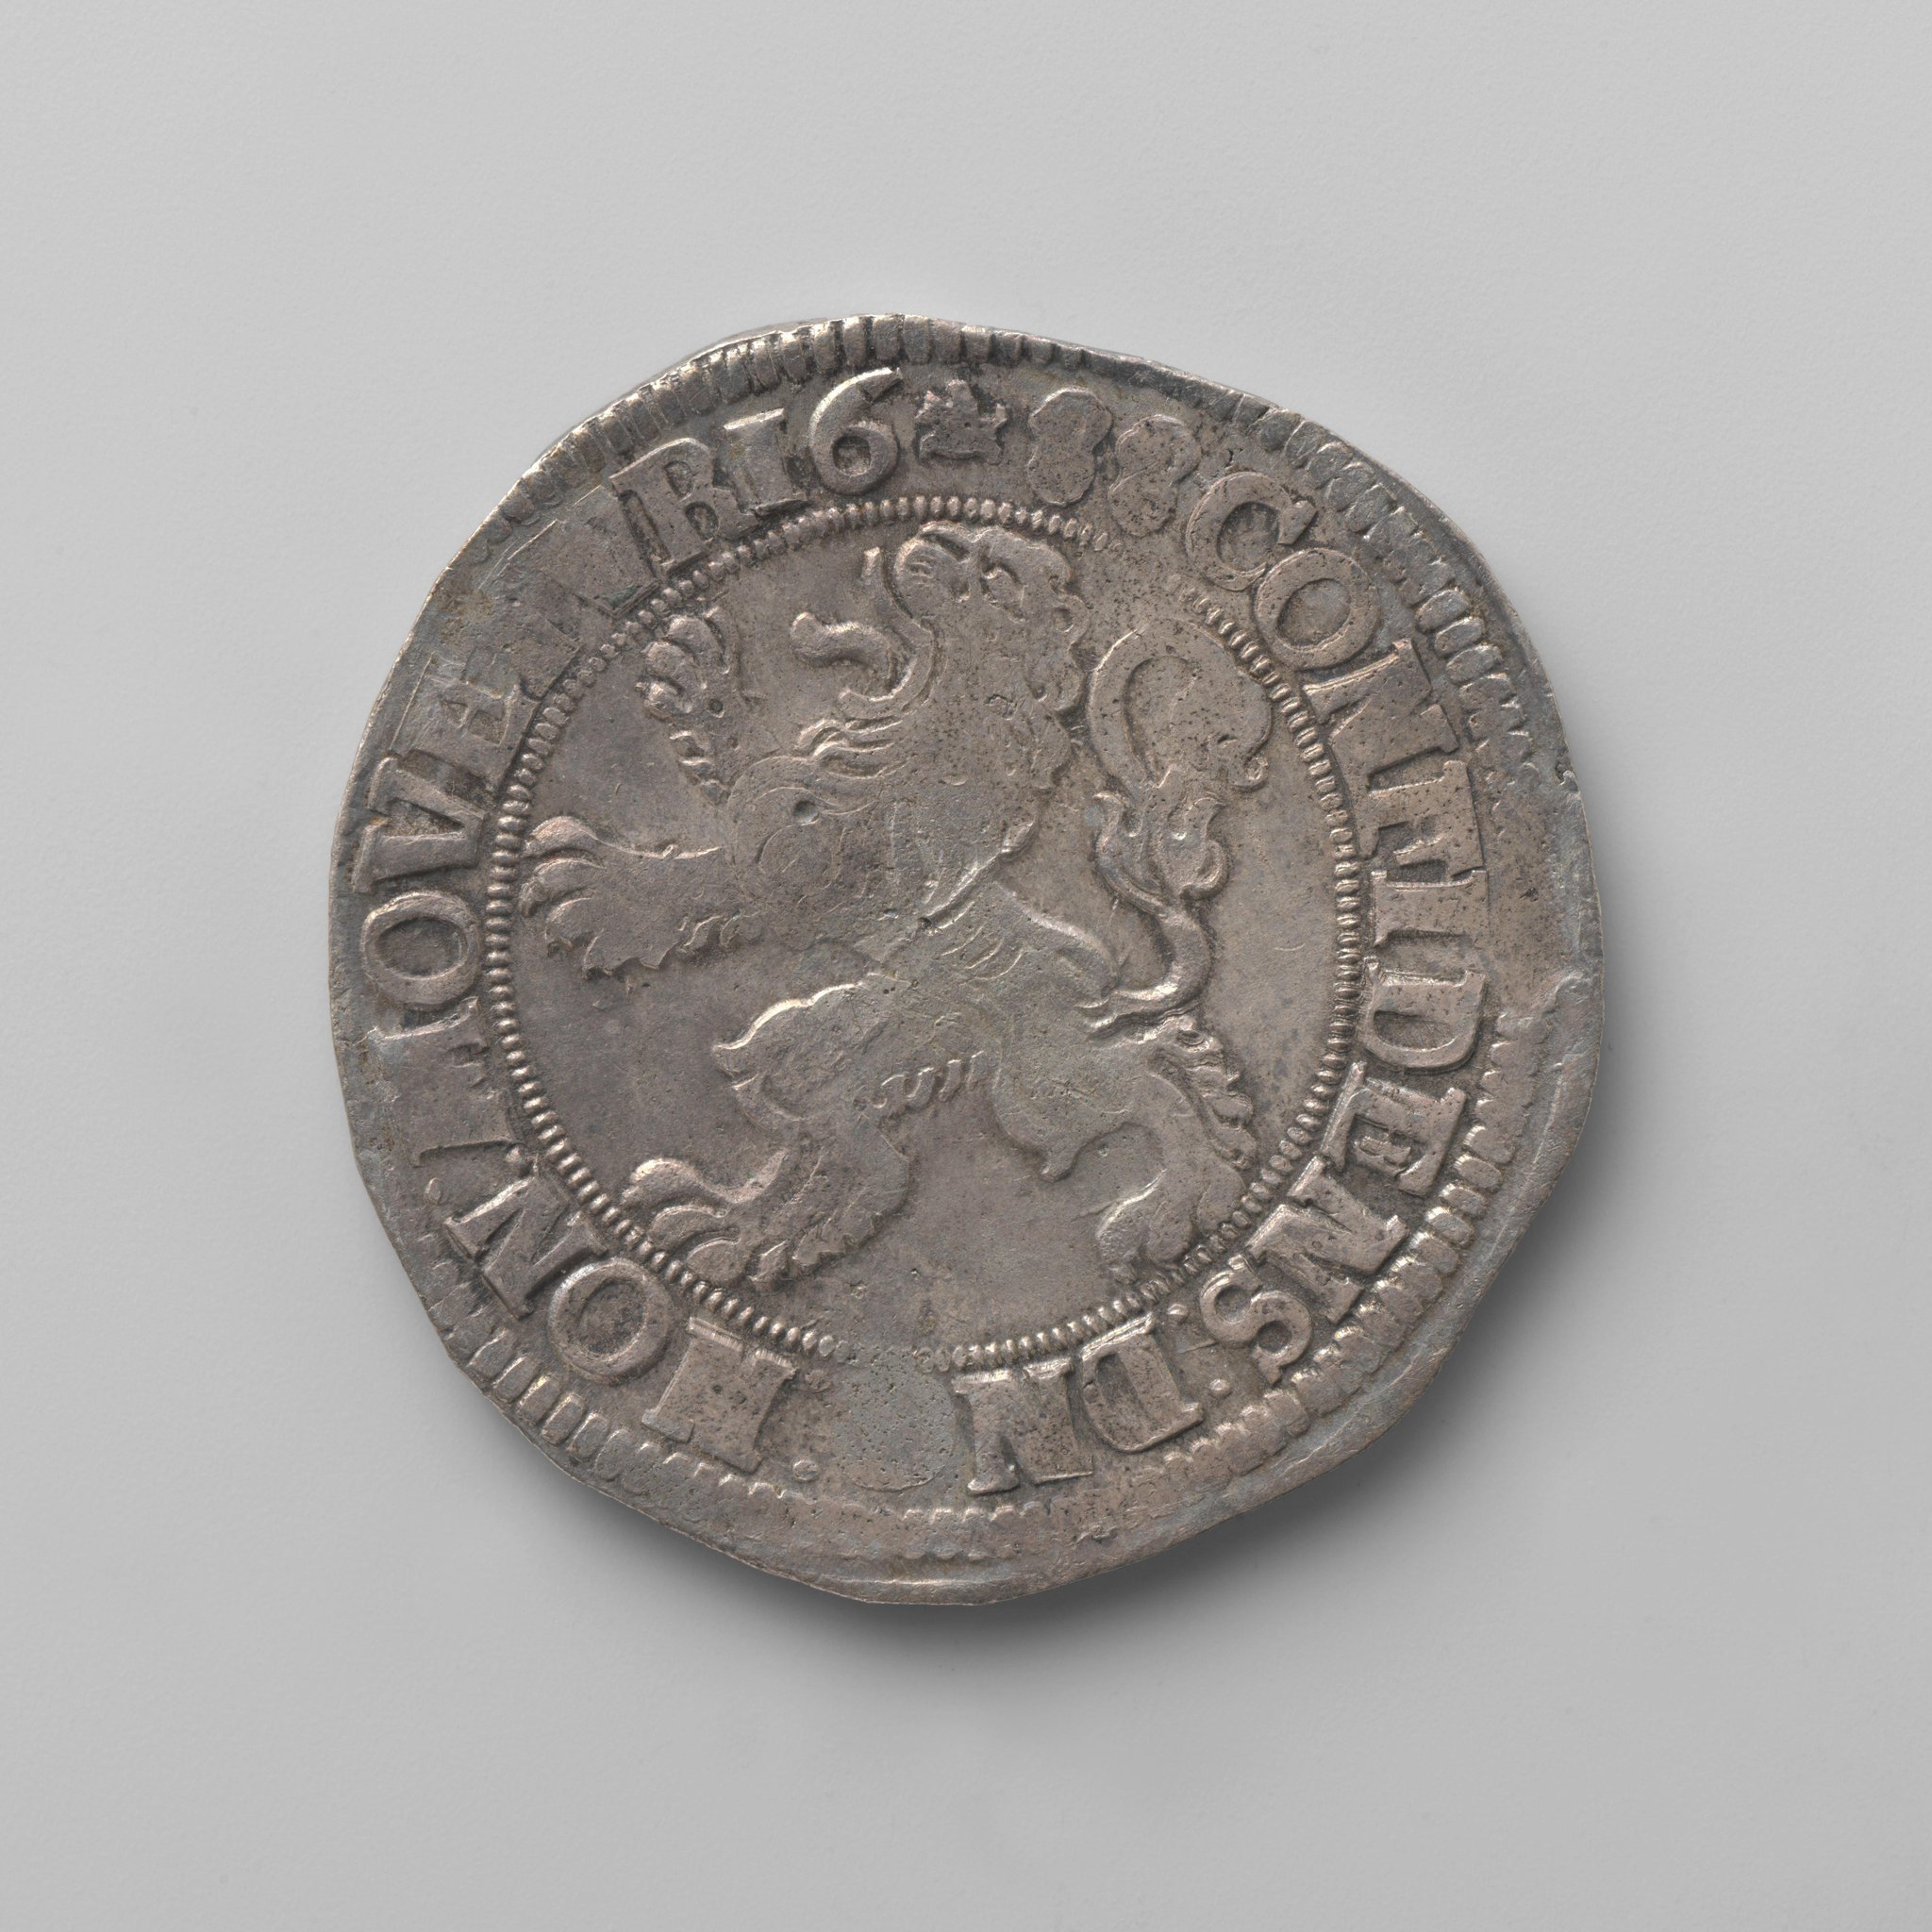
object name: leeuwendaalder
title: Leeuwendaalder van Kampen, 1688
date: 1688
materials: silver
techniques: striking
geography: kampen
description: Zilveren munt. Voorzijde: ridder met helm zonder pluim naar rechts kijkend metvoor zich wapenschild met klimmende leeuw. Keerzijde: Klimmende leeuw naar links. Jaartal in omschrift.